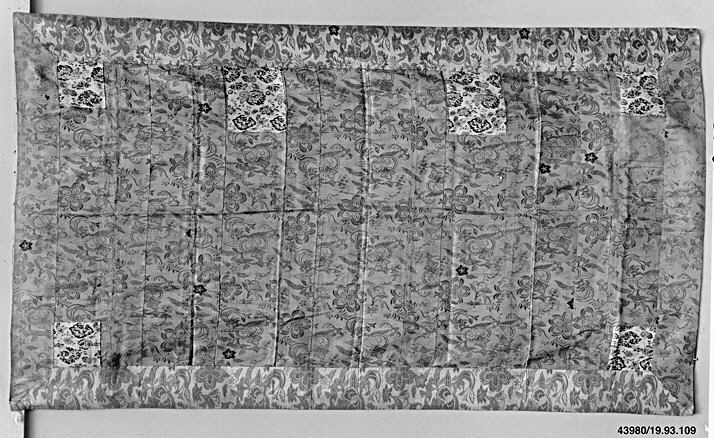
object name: robe, priest's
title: Priest's Robe (Shichijō)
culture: japanese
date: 1625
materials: silk